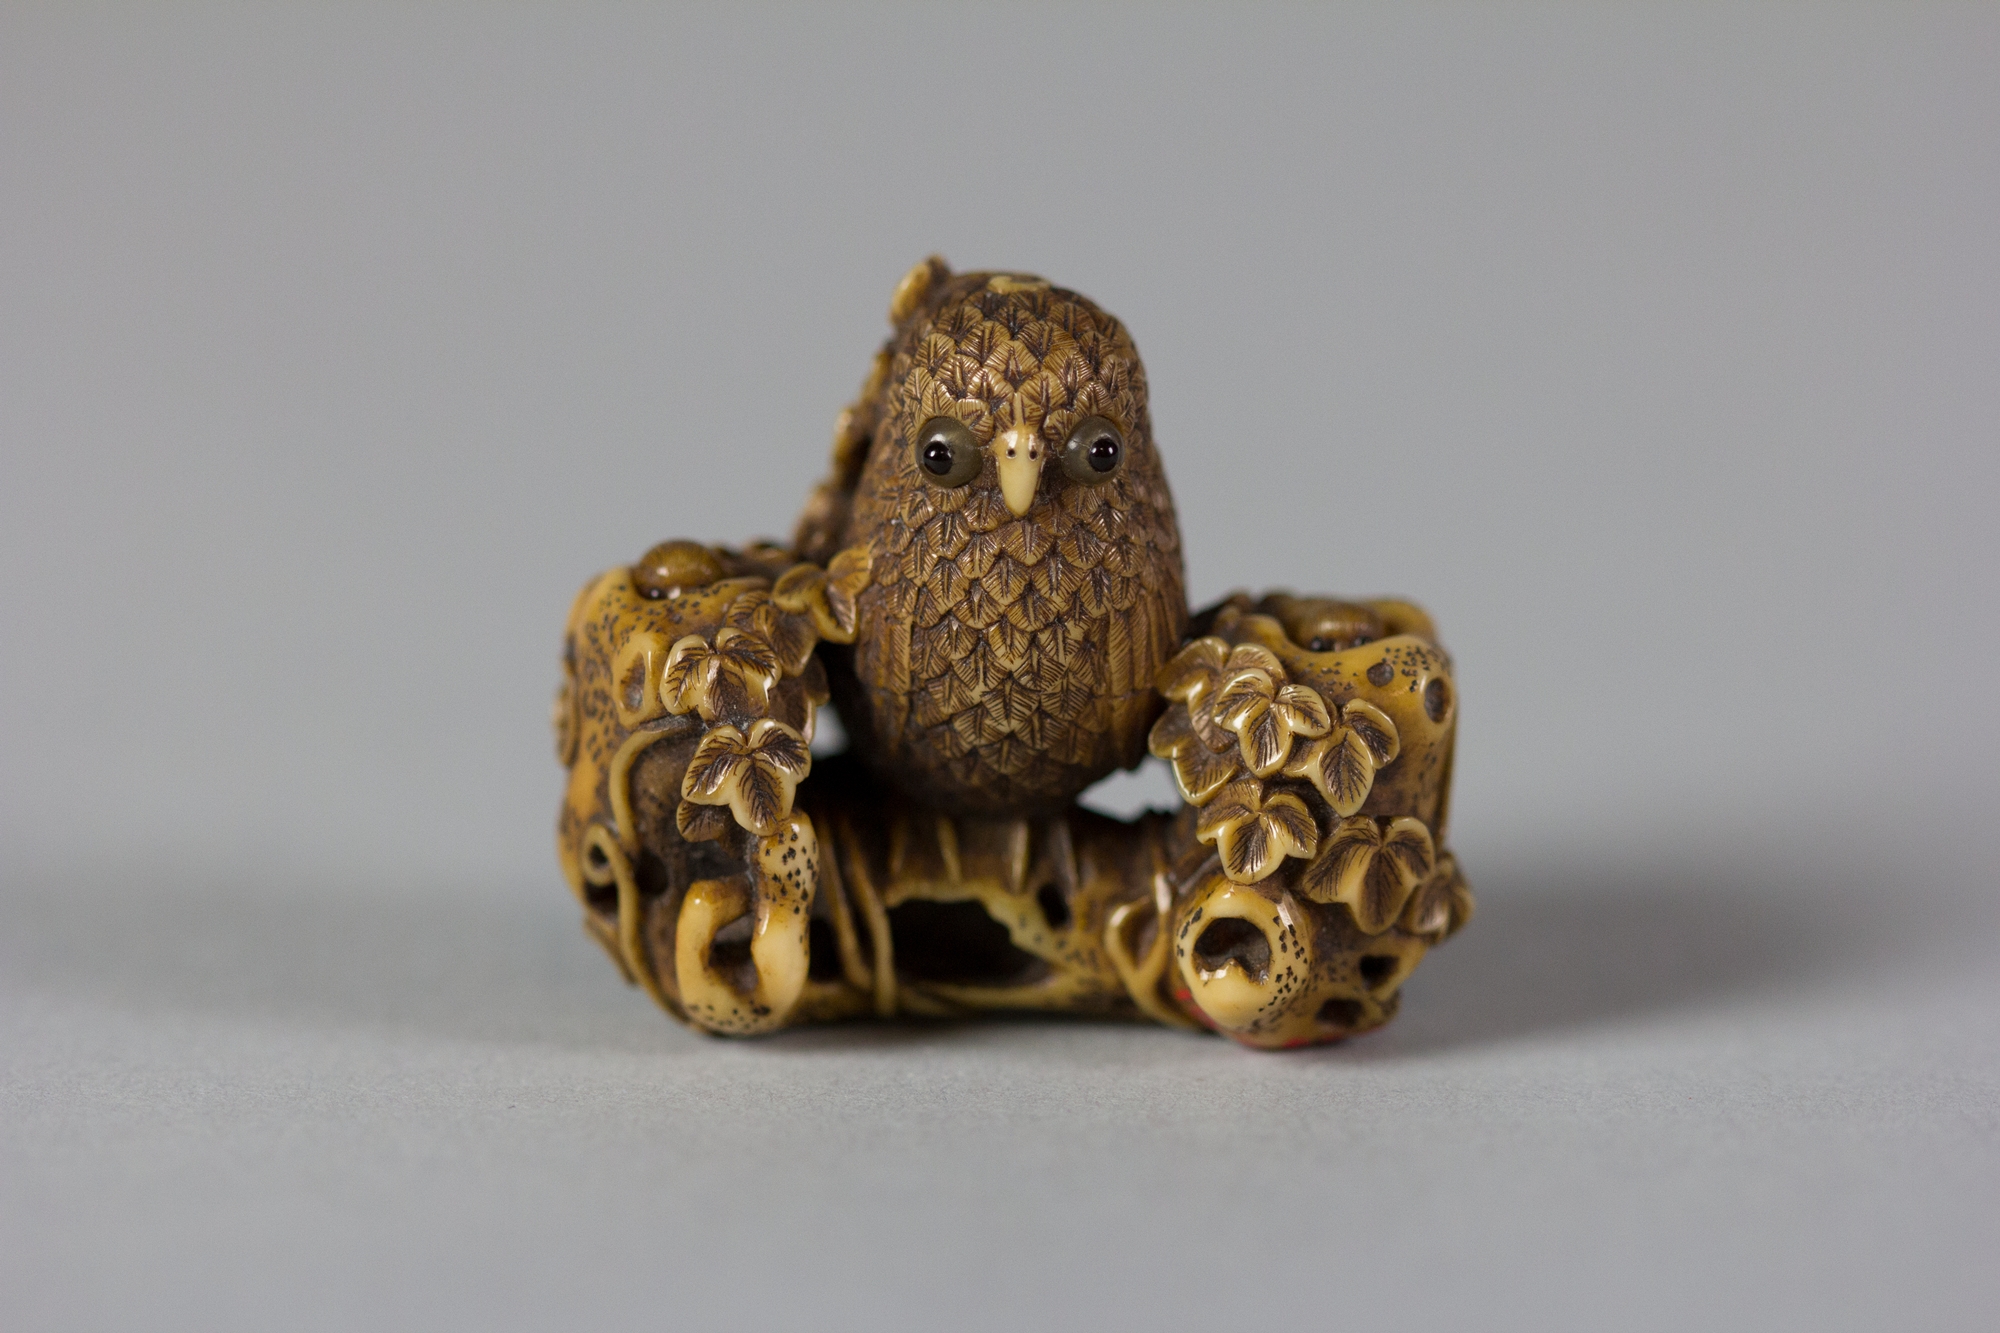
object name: netsuke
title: Netsuke of Owl and Two Owlets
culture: japanese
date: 1701-1900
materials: ivory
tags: owls